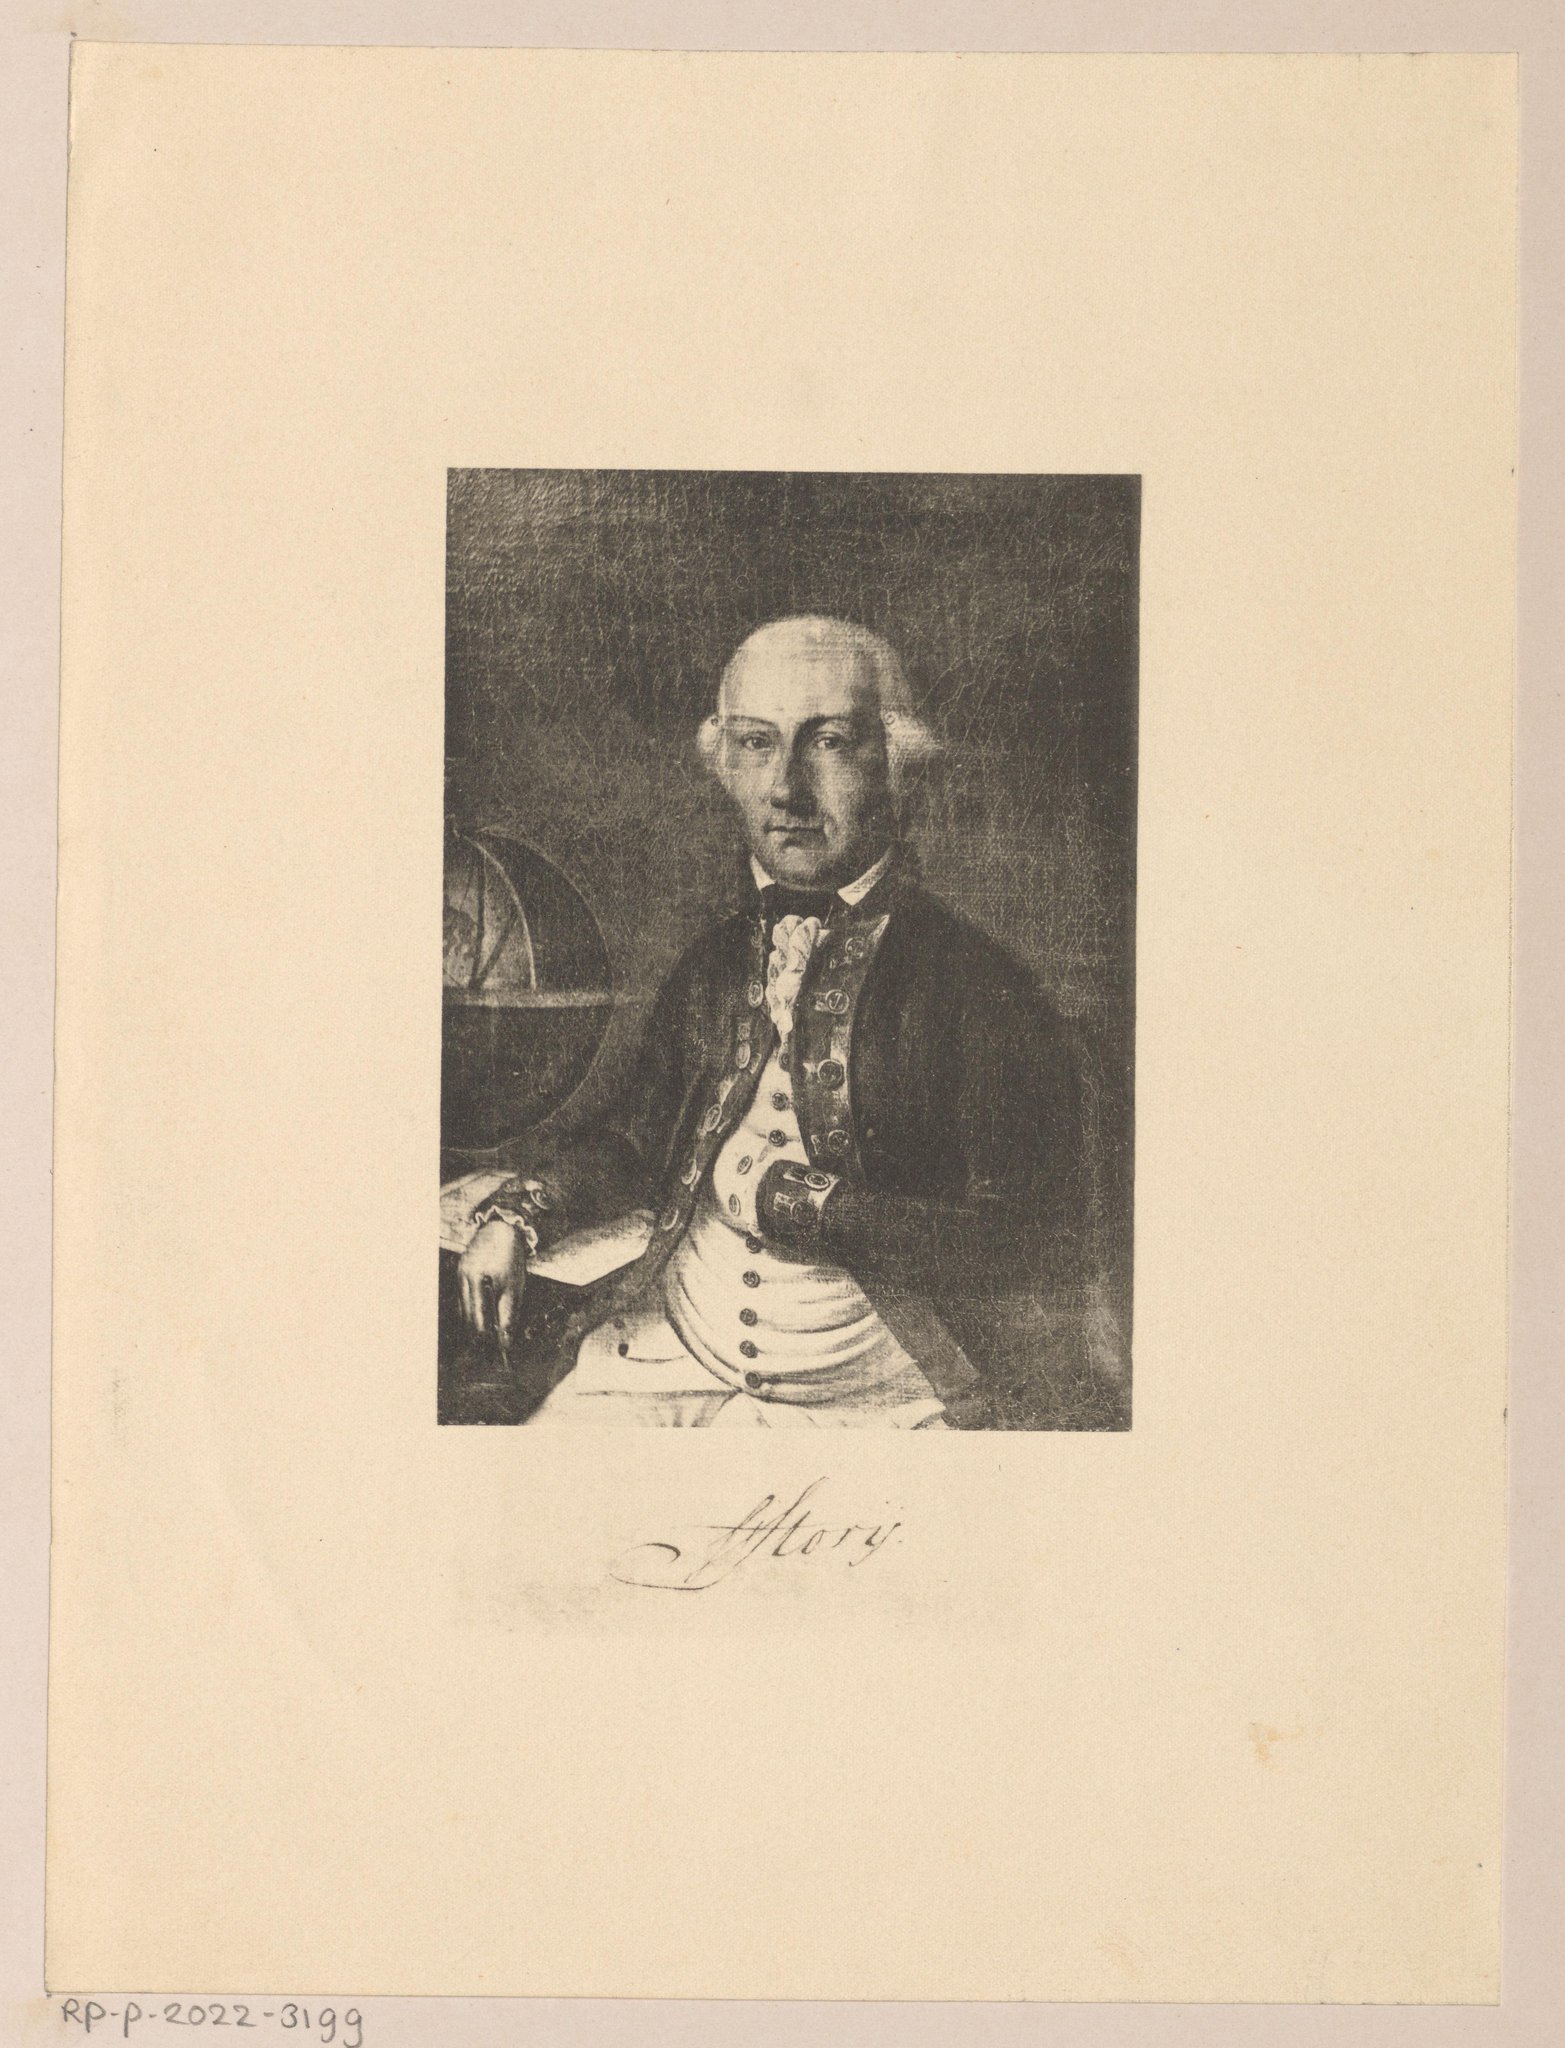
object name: photomechanical print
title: Portret van Samuel Story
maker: Anonymous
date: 1875-1930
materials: paper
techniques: photograph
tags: cleves, historical persons, commander-in-chief, admiral